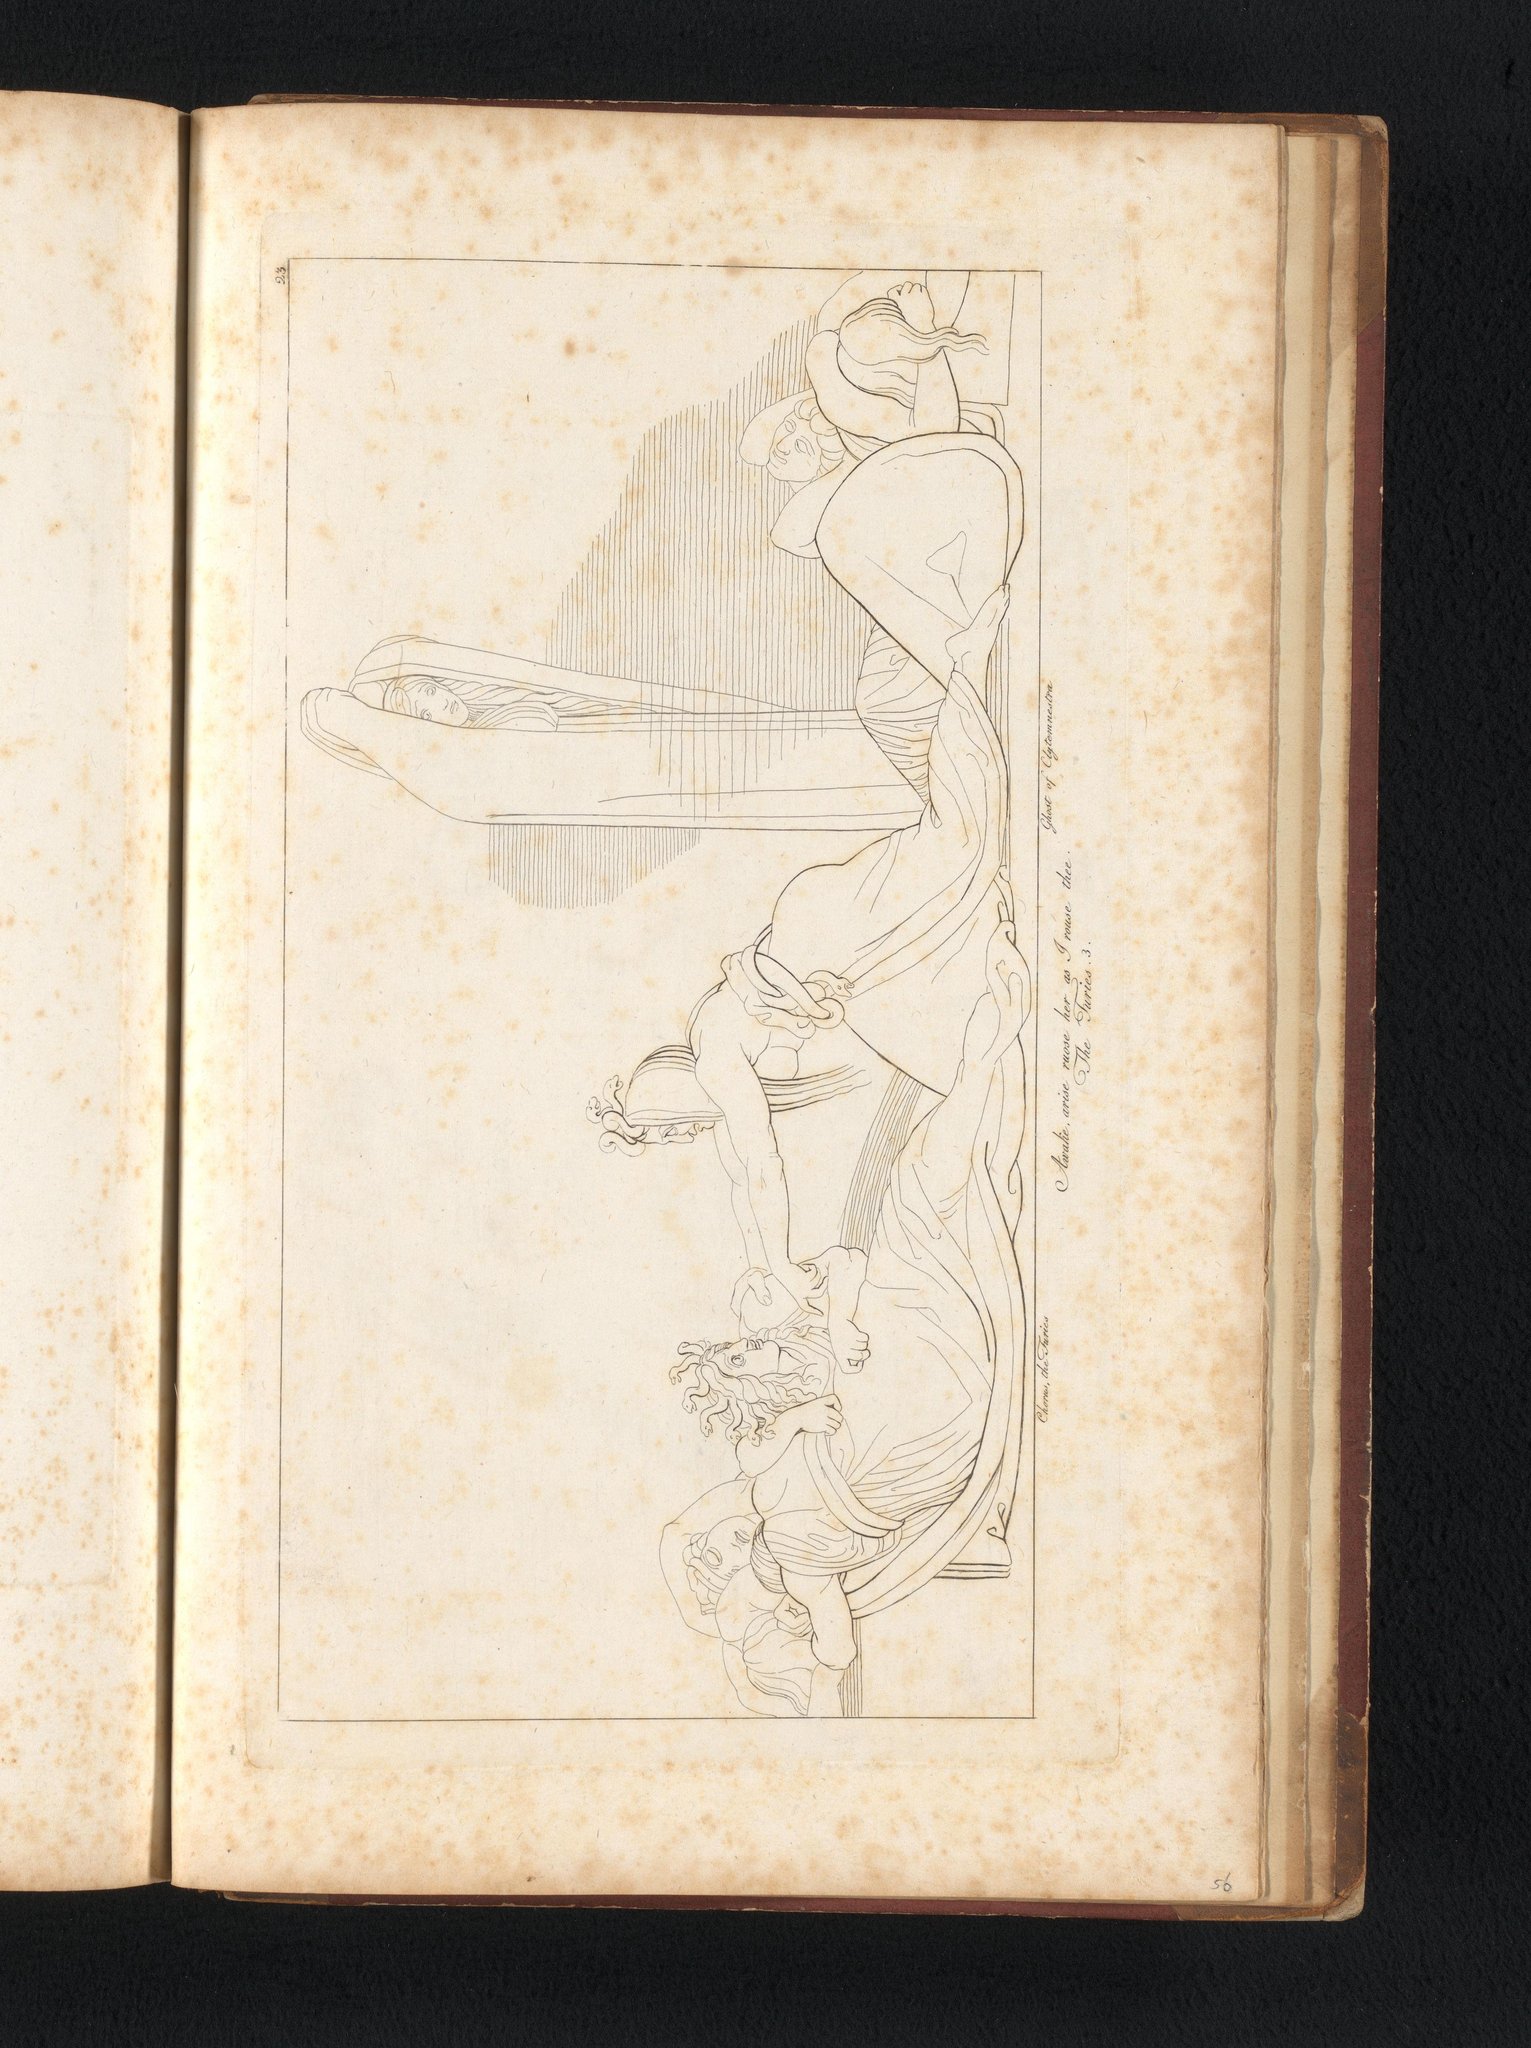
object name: print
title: Awake, arise, rouse her as I rose thee. The Furies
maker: tommaso piroli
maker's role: print maker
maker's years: 1752-1824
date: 1795-1816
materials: paper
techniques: engraving, etching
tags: furies, dirae (erinyes), eumenides; 'furie' (ripa)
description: Ingeplakte prent van het wekken van de Furiën. Genummerd rechtsboven: 23. Onderdeel van het tweede van twee albums met ingeplakte prenten en tekeningen te dienen als tekenvoorbeelden.